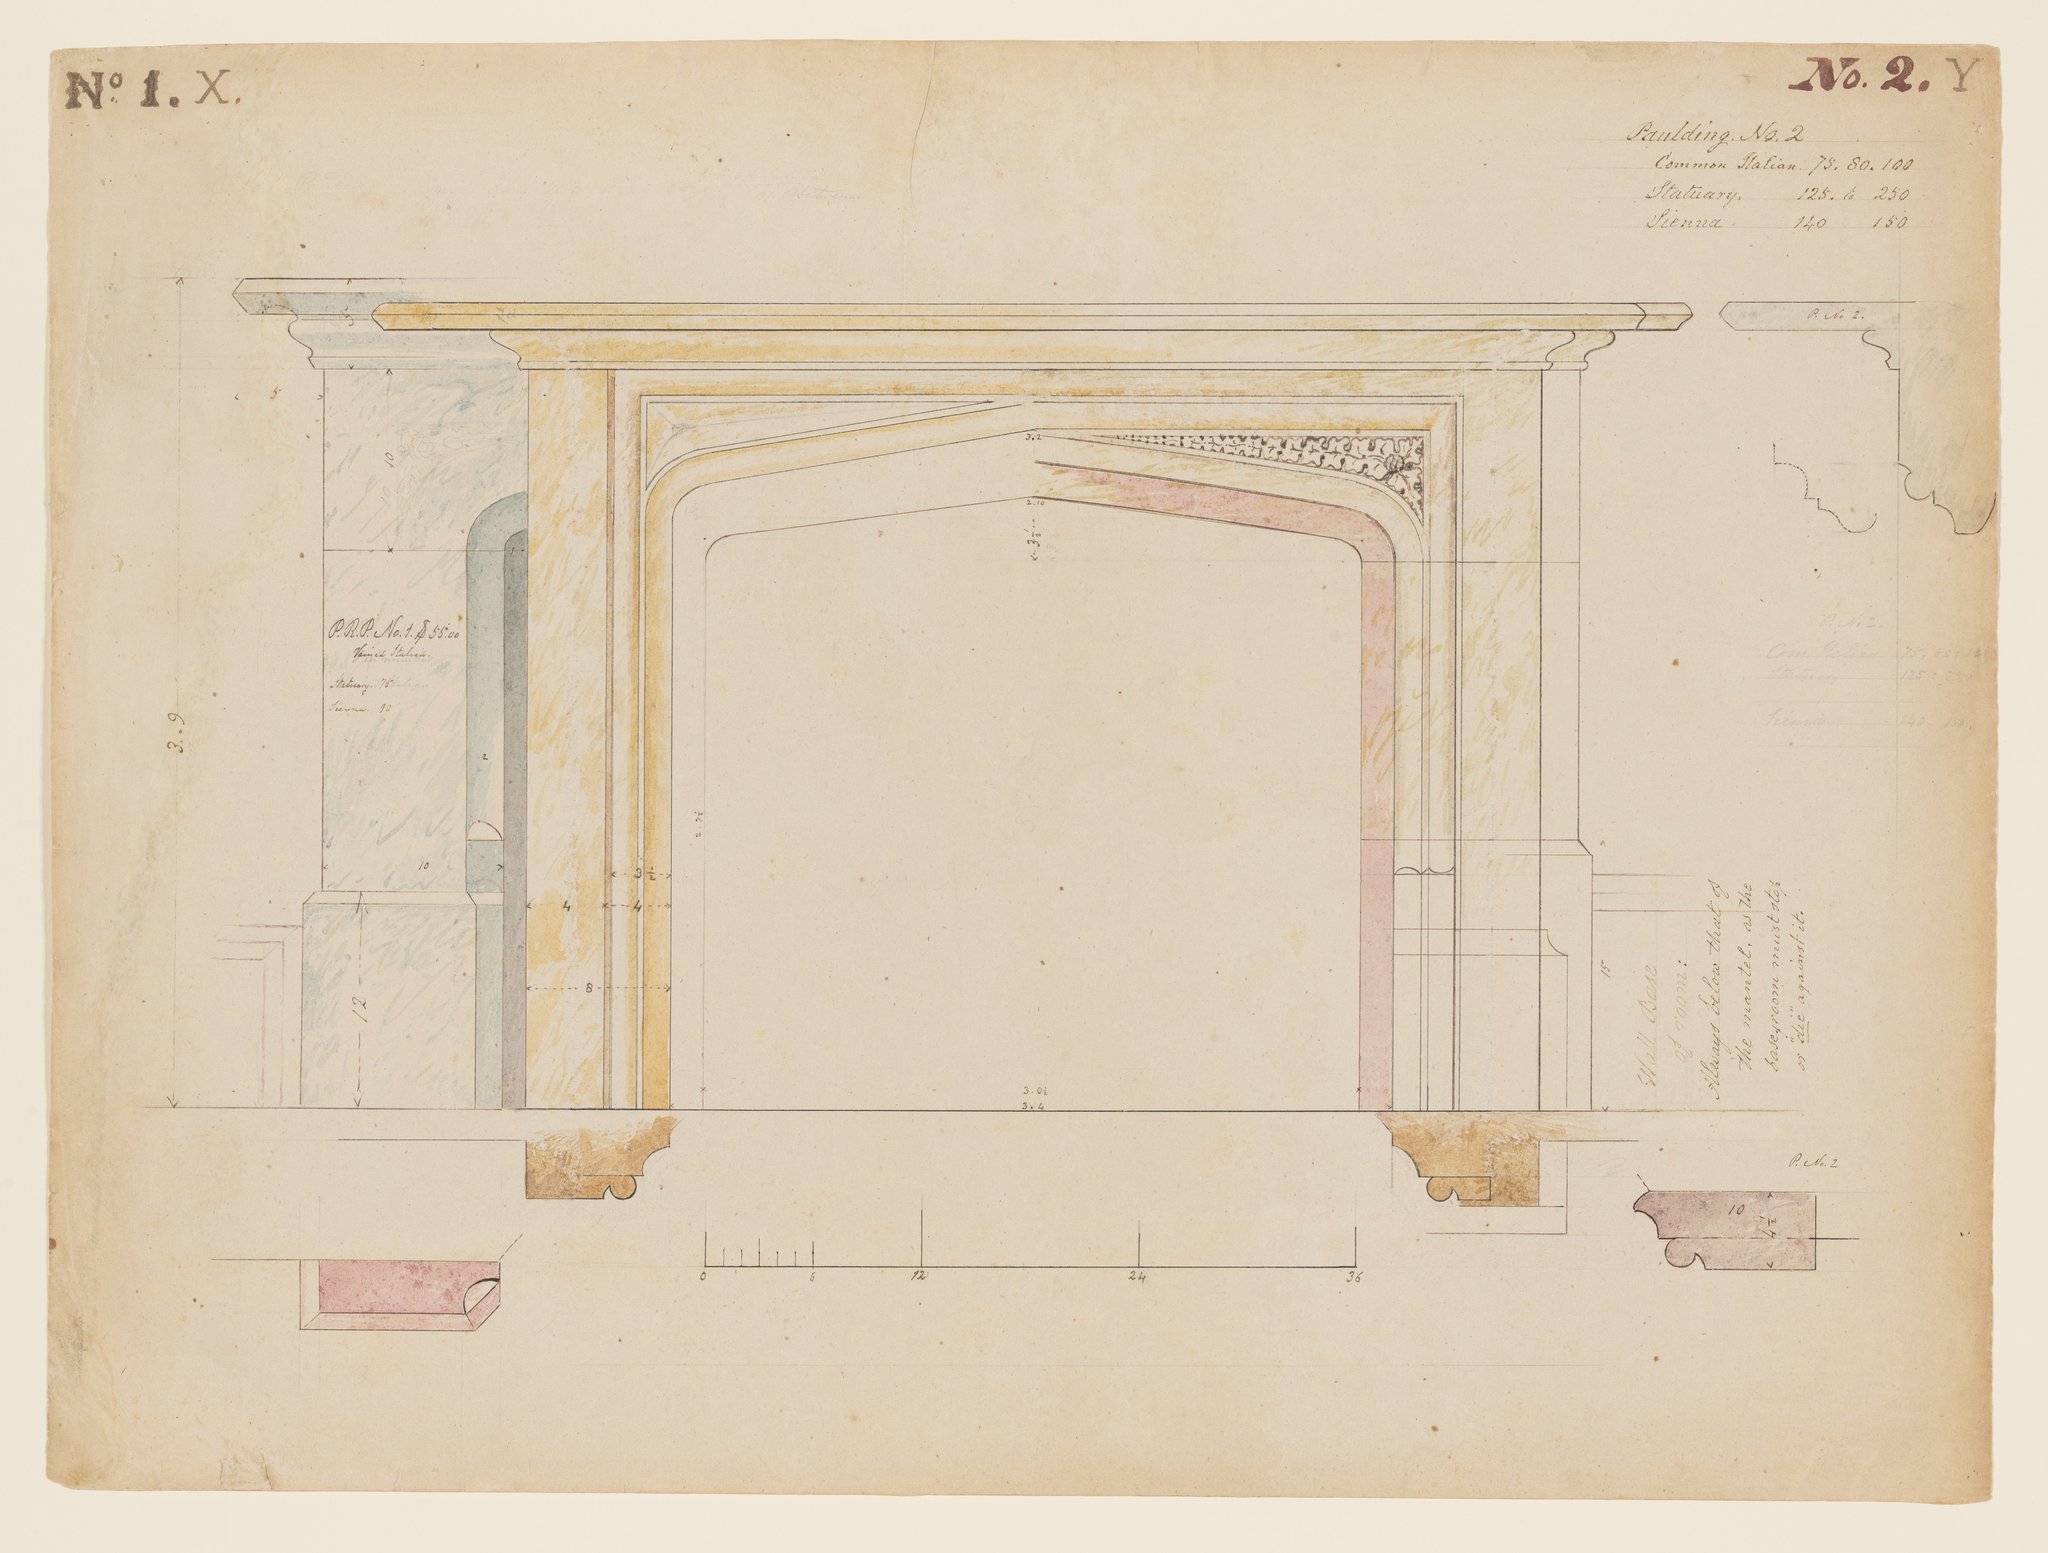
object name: drawing ornament architecture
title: Technical Drawing of a Fireplace Mantel for Knoll (now Lyndhurst), Tarrytown, New York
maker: alexander jackson davis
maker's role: artist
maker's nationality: american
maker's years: 1803-1892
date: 1838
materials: graphite, ink, watercolor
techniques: pen